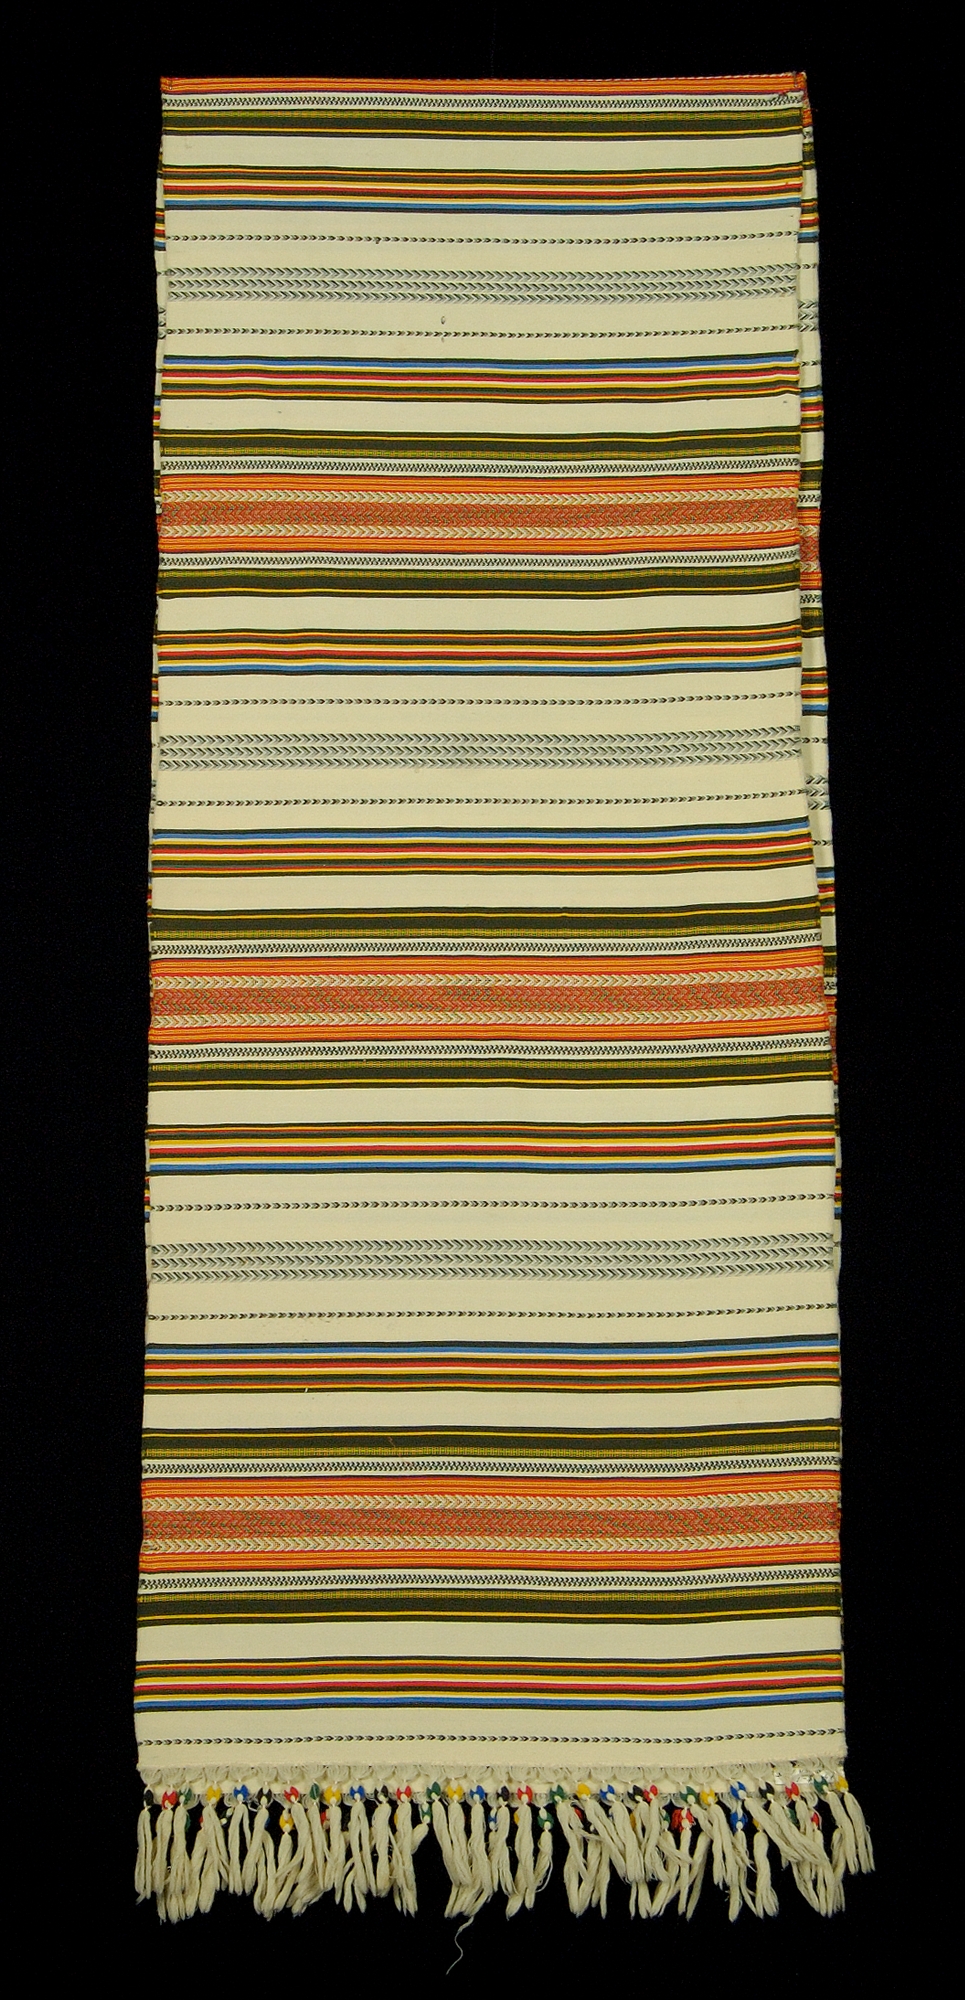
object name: sash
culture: italian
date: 1851-1875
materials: wool